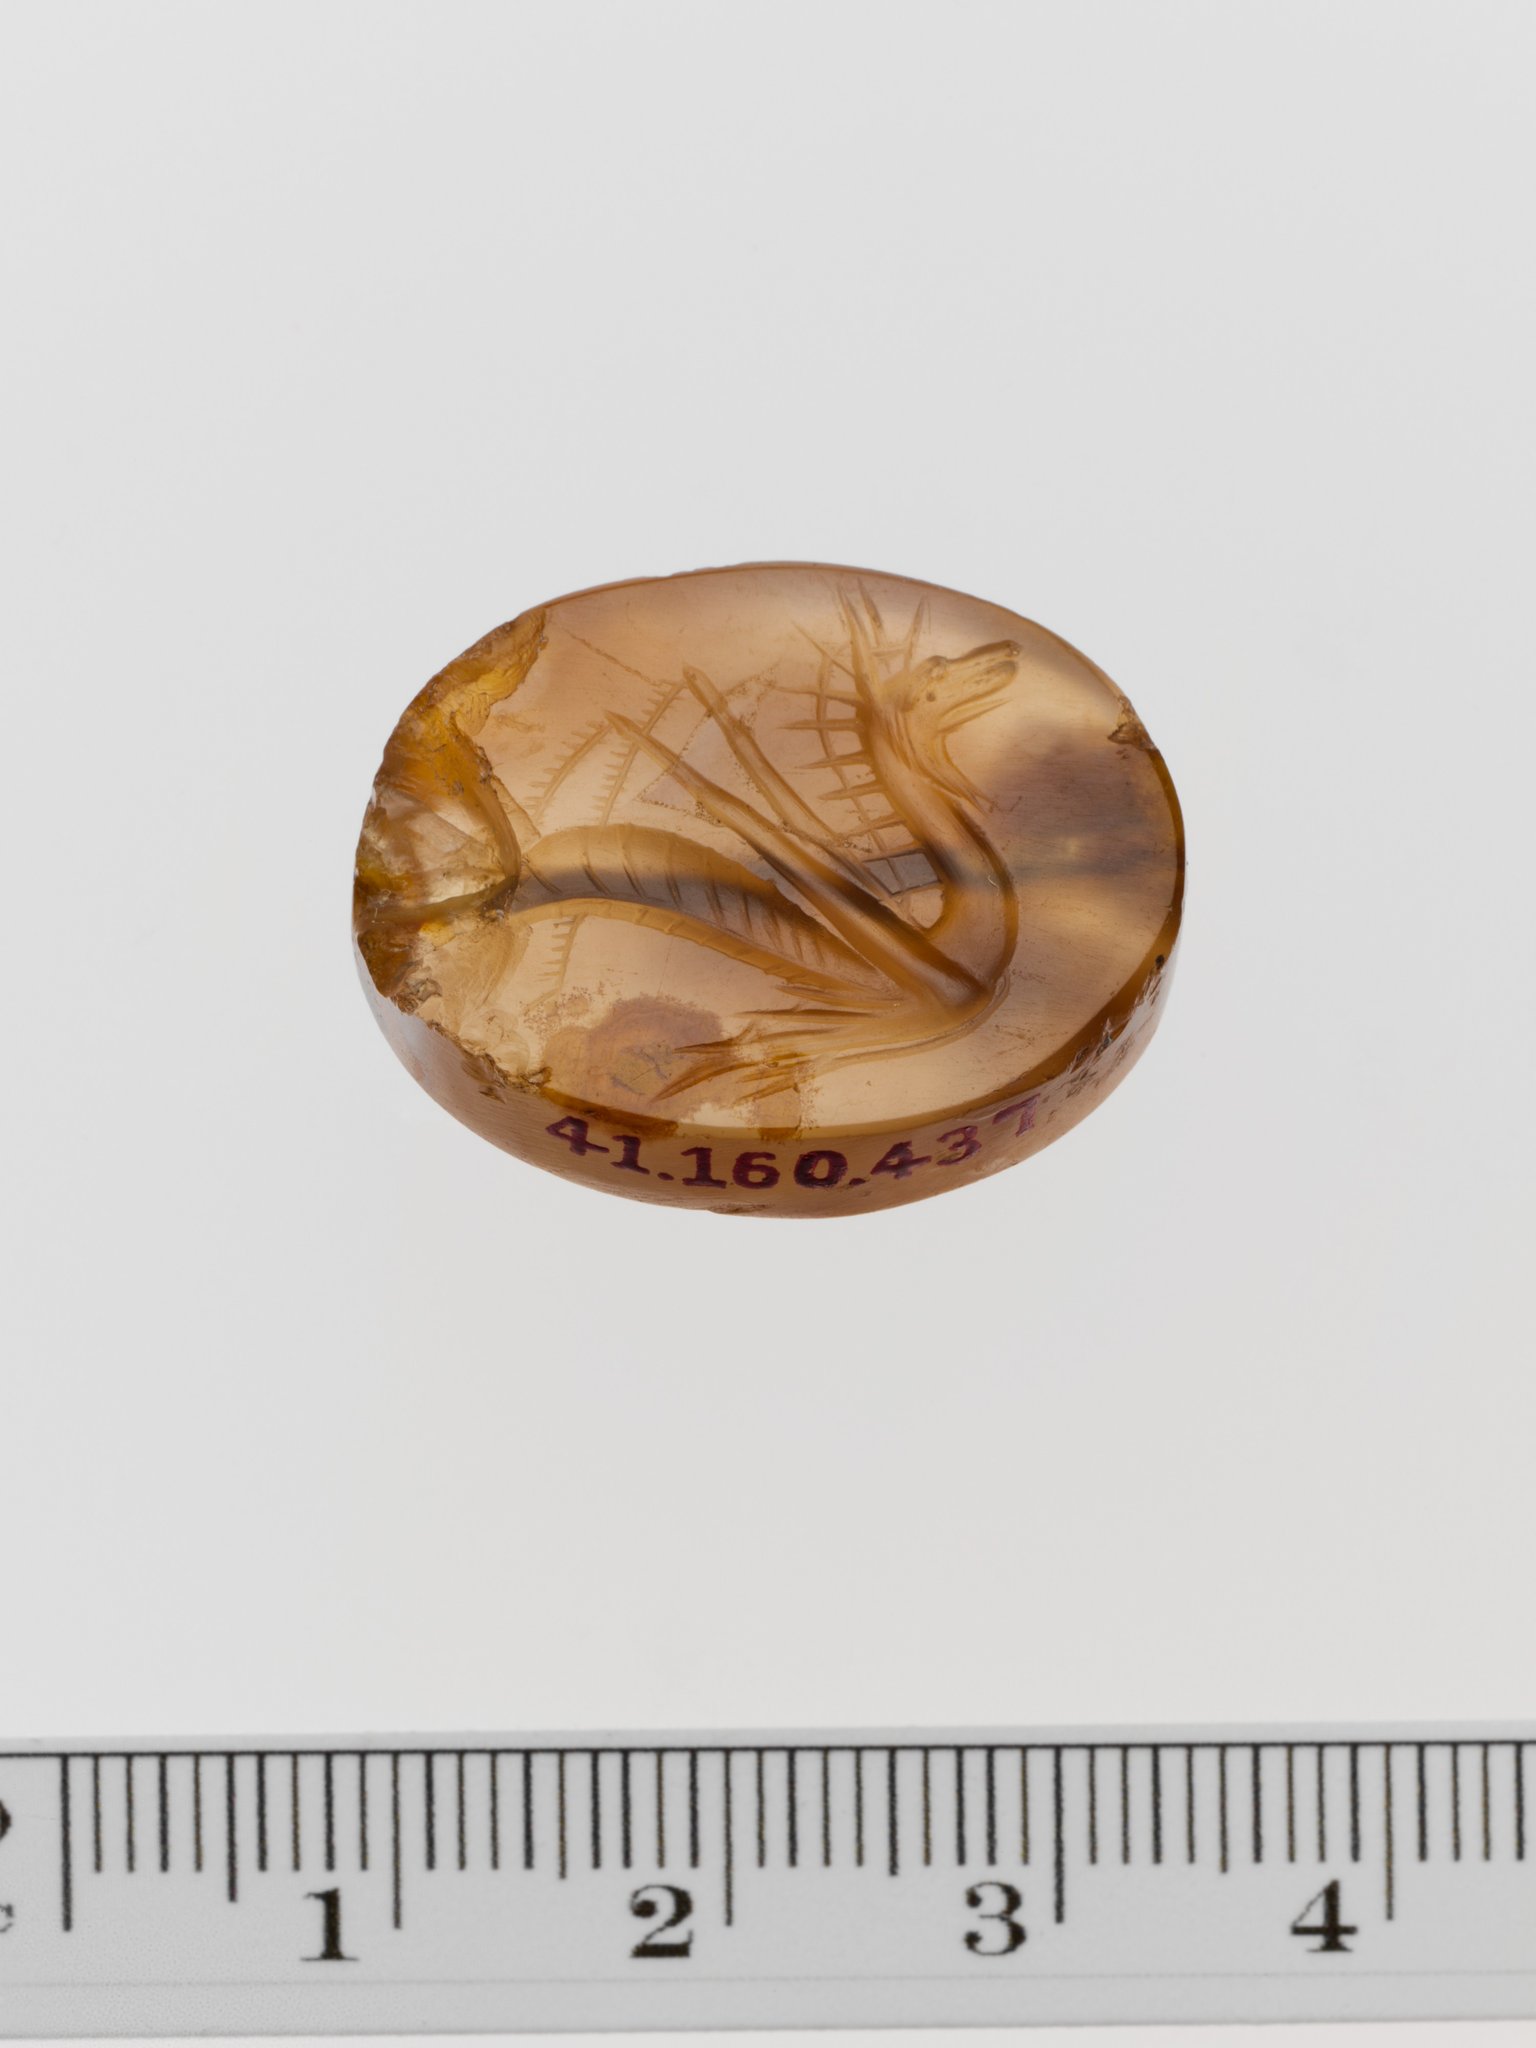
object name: scaraboid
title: Chalcedony scaraboid seal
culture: greek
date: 450-400 BCE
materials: stone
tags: monsters